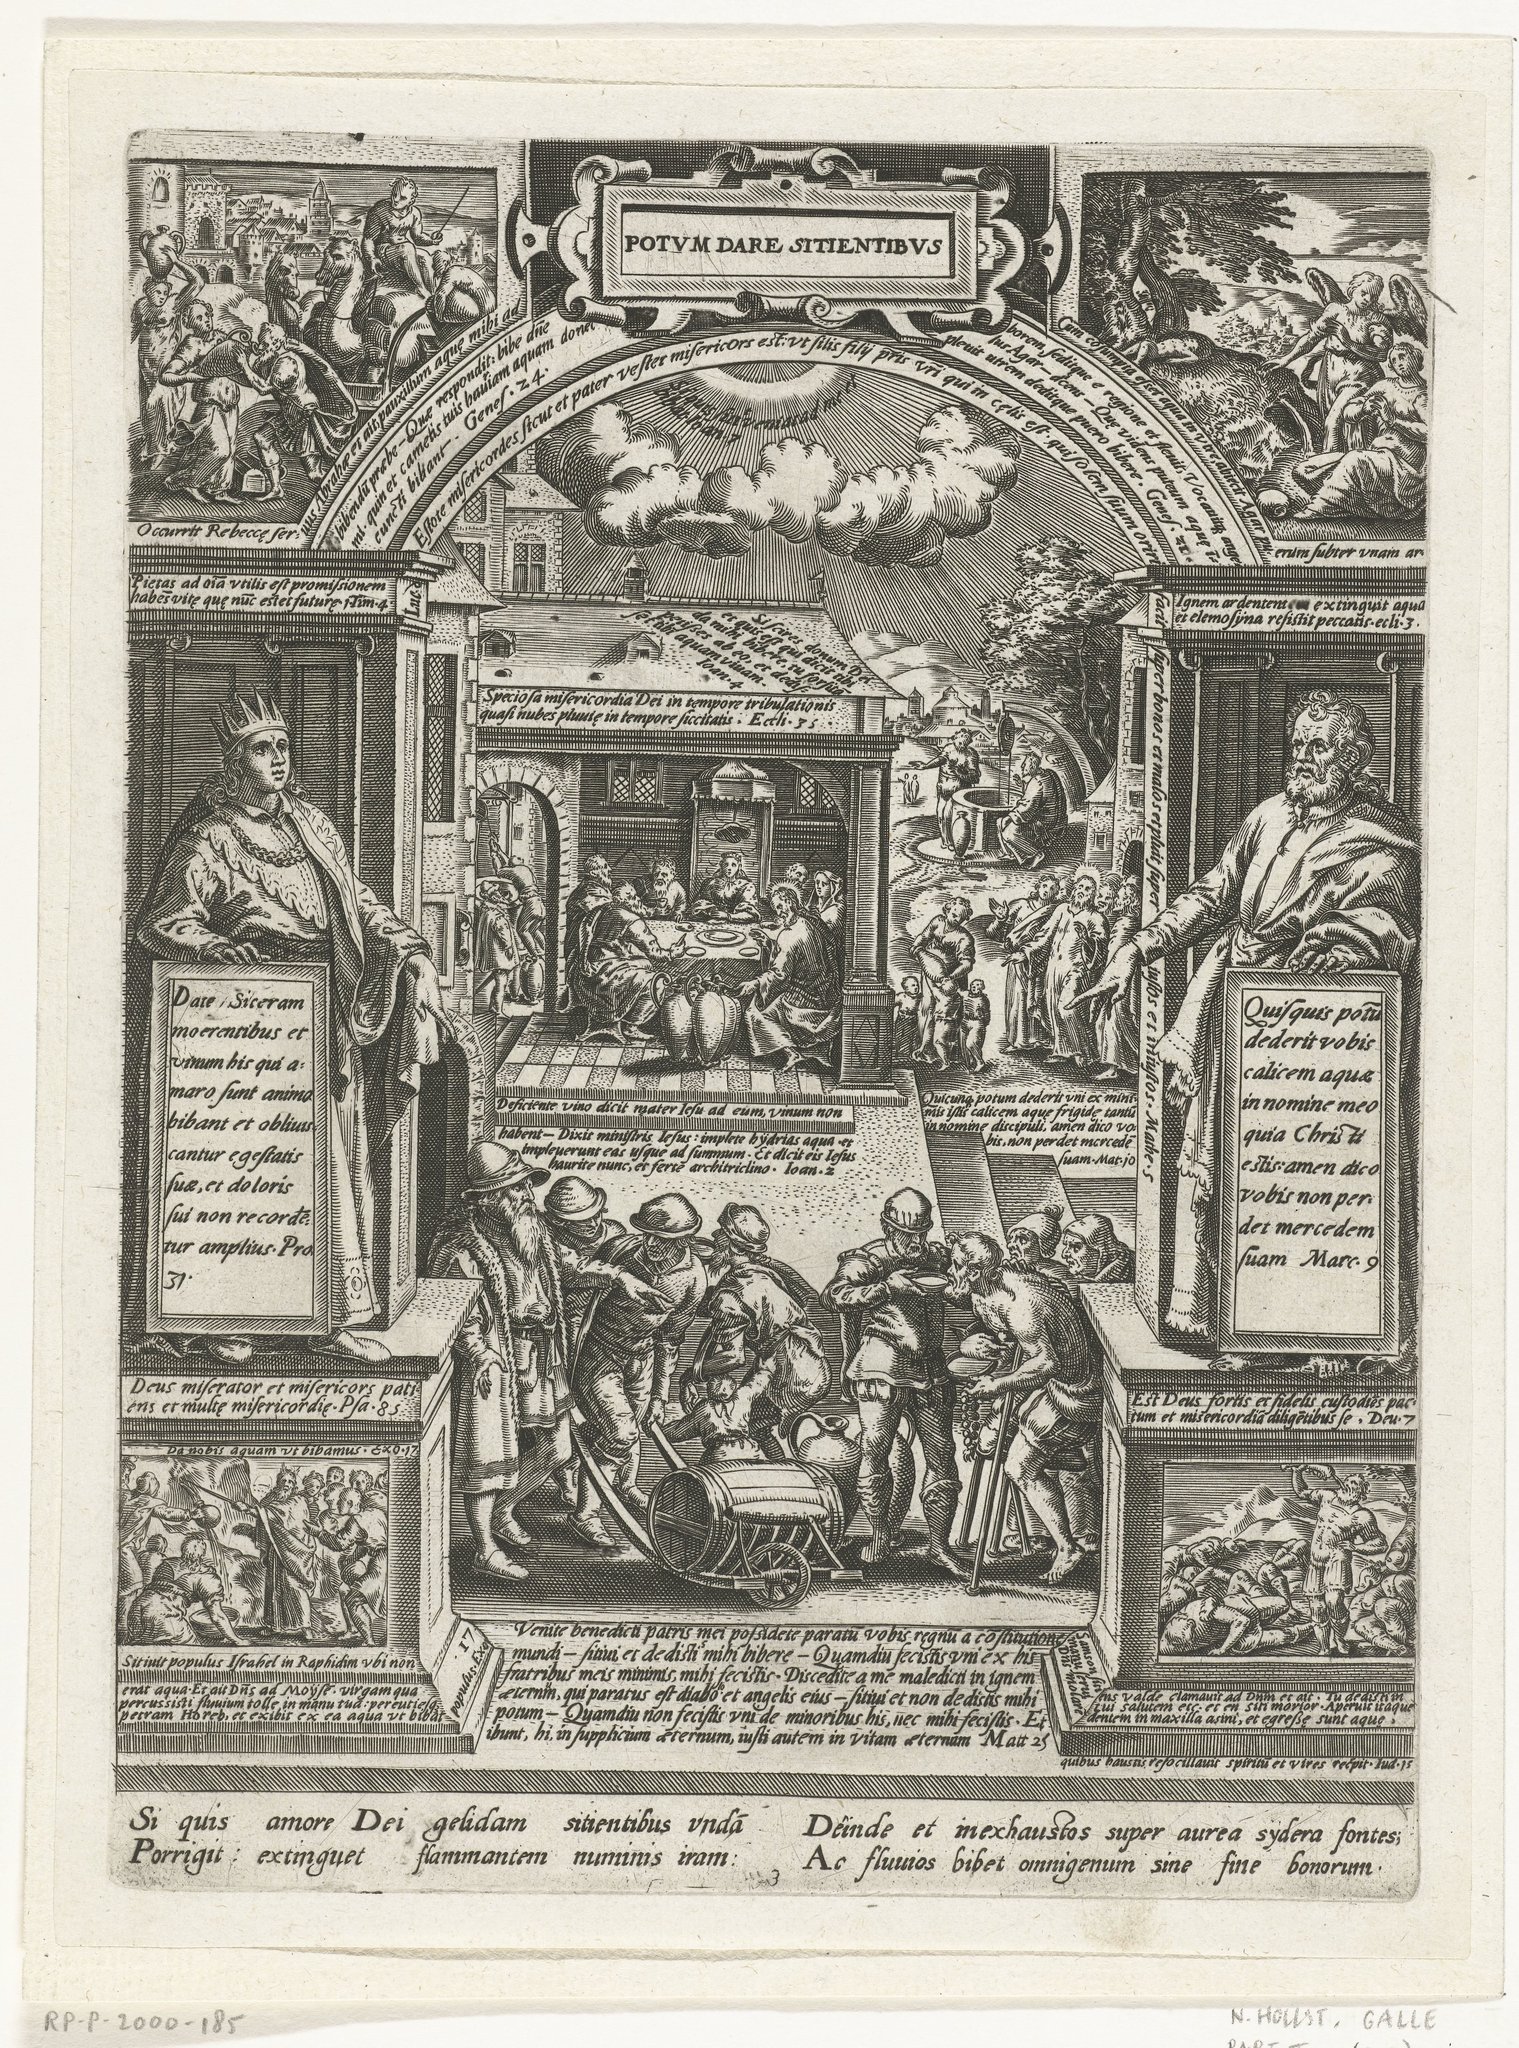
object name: print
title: De zeven werken van barmhartigheid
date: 1577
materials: paper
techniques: engraving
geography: low countries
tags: moses strikes the rock twice in front of the assembled people and water gushes out; the people quench their thirst, christ orders (six) jars to be filled with water ~ marriage-feast at cana, giving the thirsty to drink, 'sitiens potatur' ~ one of the (seven) acts of mercy, the meeting at the well: eliezer sees rebekah coming with a pitcher, hagar and ishmael in the wilderness, samson drinks water from a well after having slain a thousand philistines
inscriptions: collector's mark: Lugt 2228, collector's mark: Lugt 2760